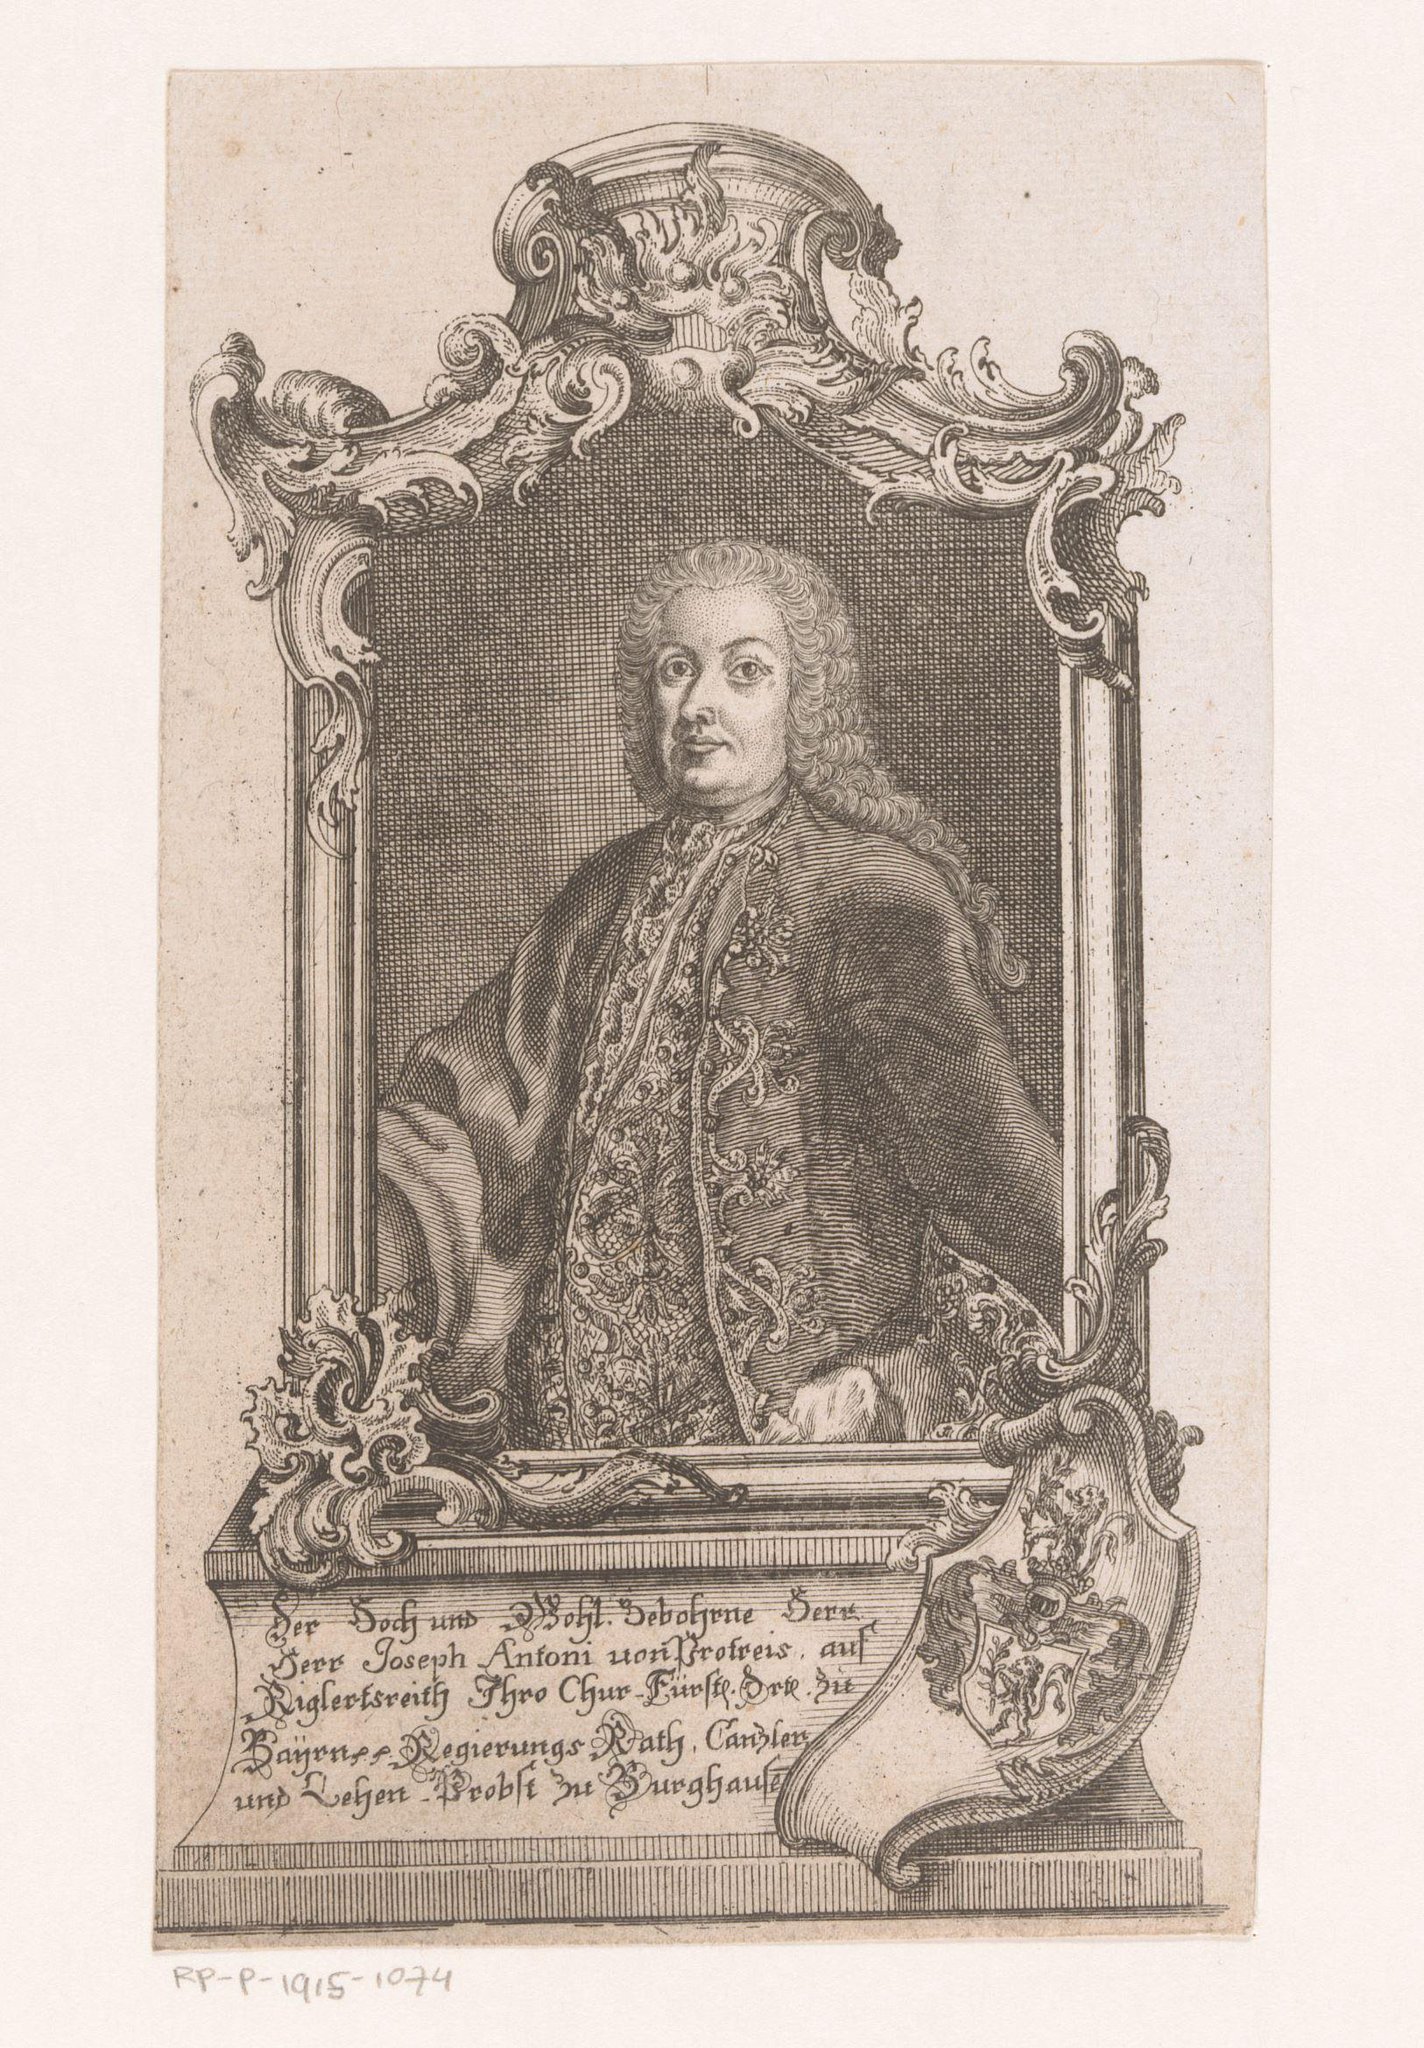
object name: print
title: Portret van Joseph Anton von Protreis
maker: joseph anton zimmermann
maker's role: draughtsman, print maker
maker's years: 1705-1797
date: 1715-1797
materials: paper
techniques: engraving, etching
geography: germany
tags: historical persons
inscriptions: collector's mark: Lugt 2228